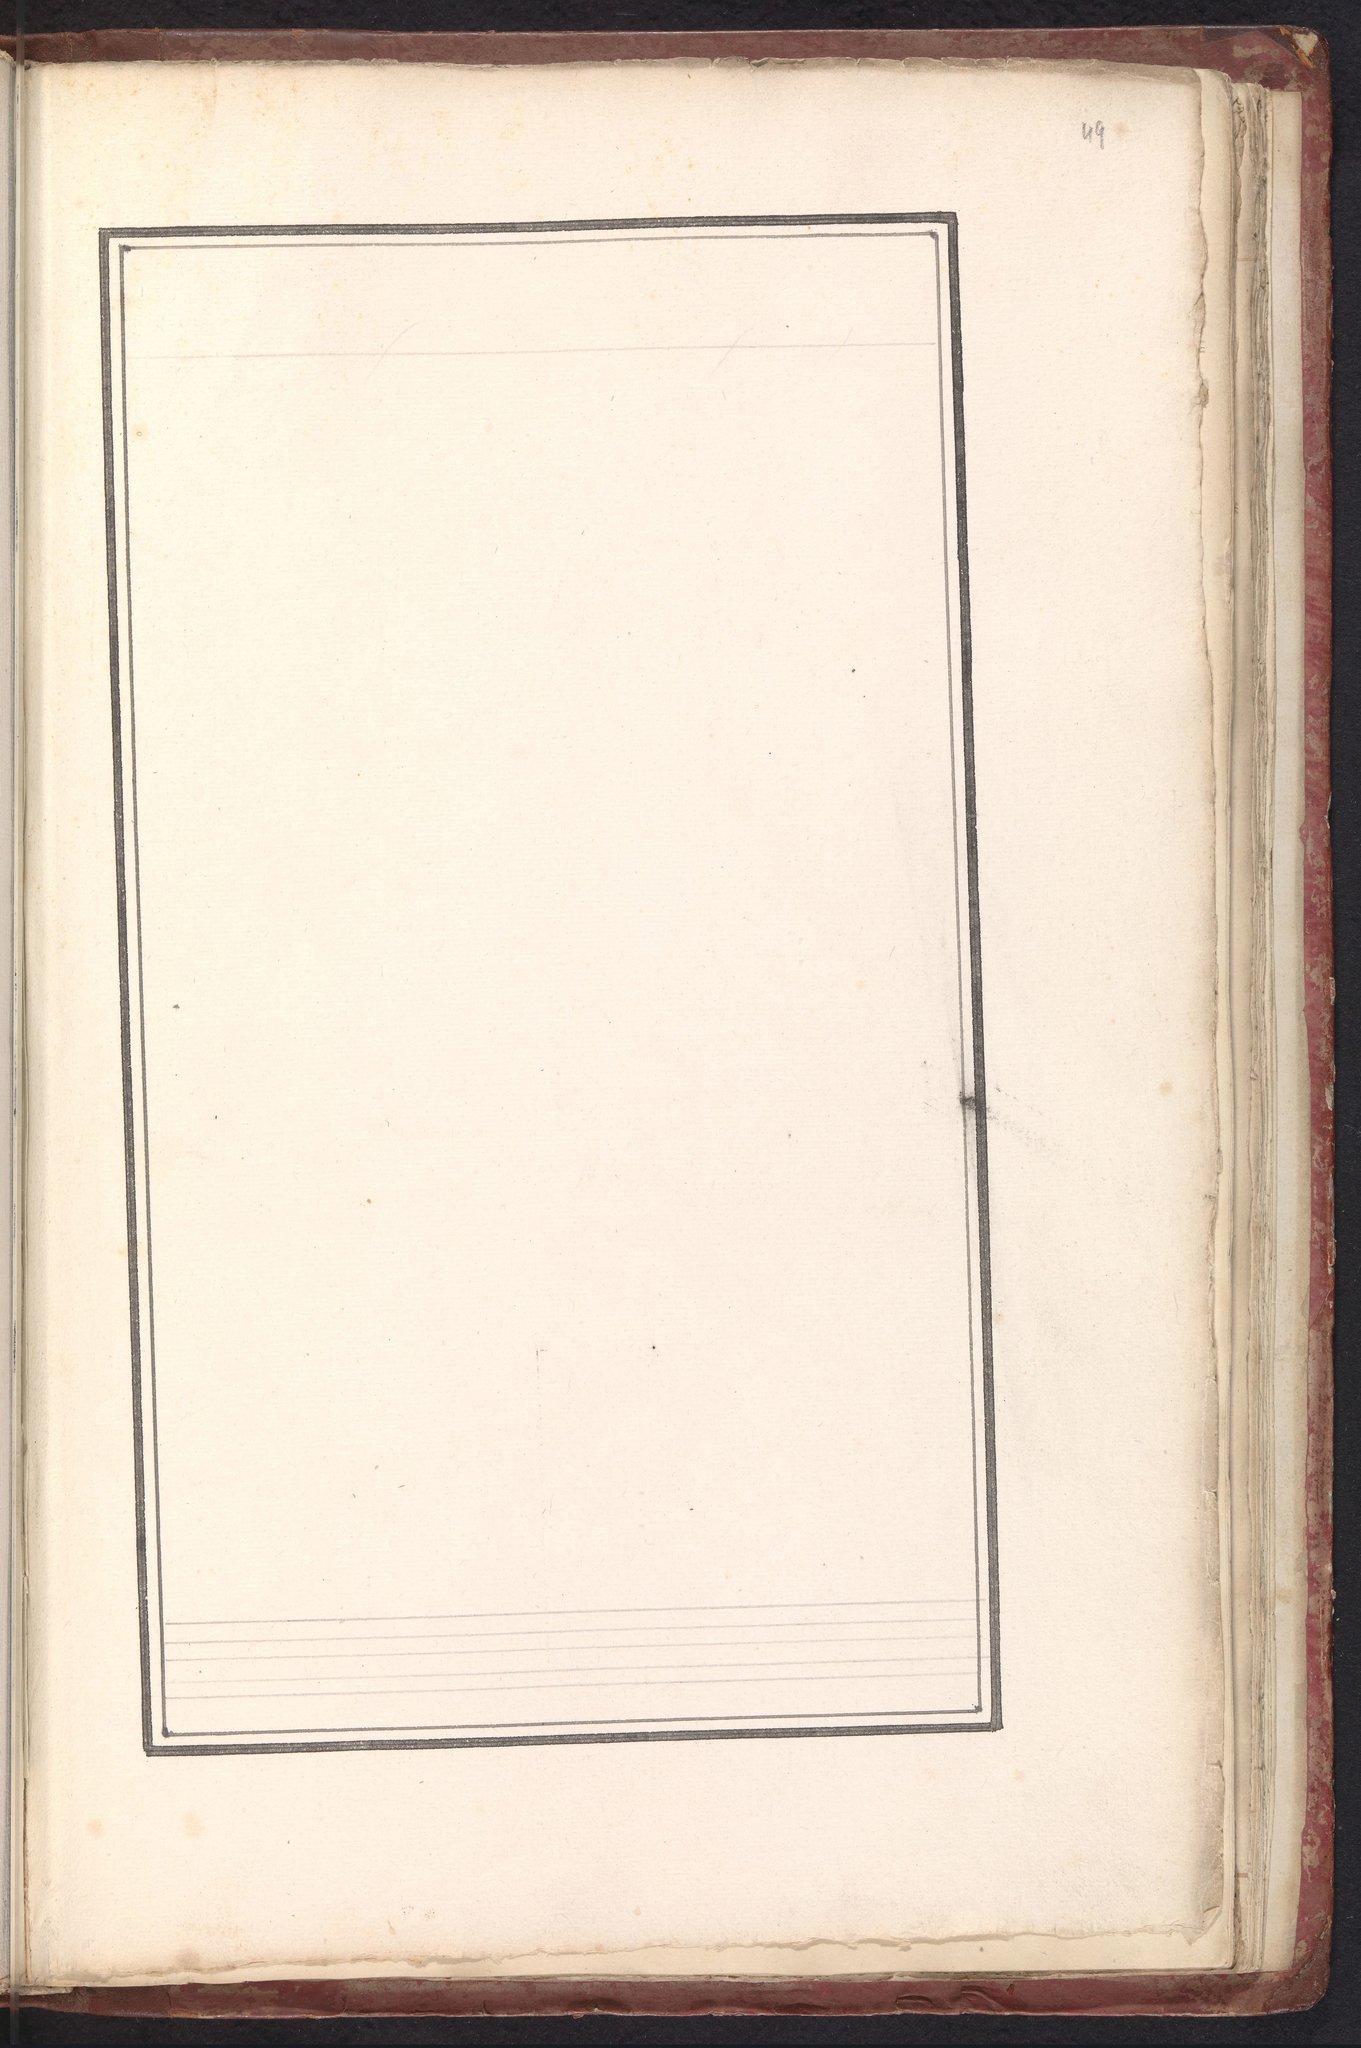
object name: drawing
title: Leeg lijst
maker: joseph van huerne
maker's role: kunstliefhebber, mecenas, verzamelaar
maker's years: 1752-1844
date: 1809-1814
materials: ink, paper, pencil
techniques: brush, pen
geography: bruges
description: Lege omlijsting. Onderdeel van het tweede album met tekeningen van viervoeters. Tweede van twaalf albums met tekeningen van dieren, vogels en planten bekend rond 1600, gemaakt in opdracht van keizer Rudolf II. Met toelichting in Nederlands, Latijn en Frans.